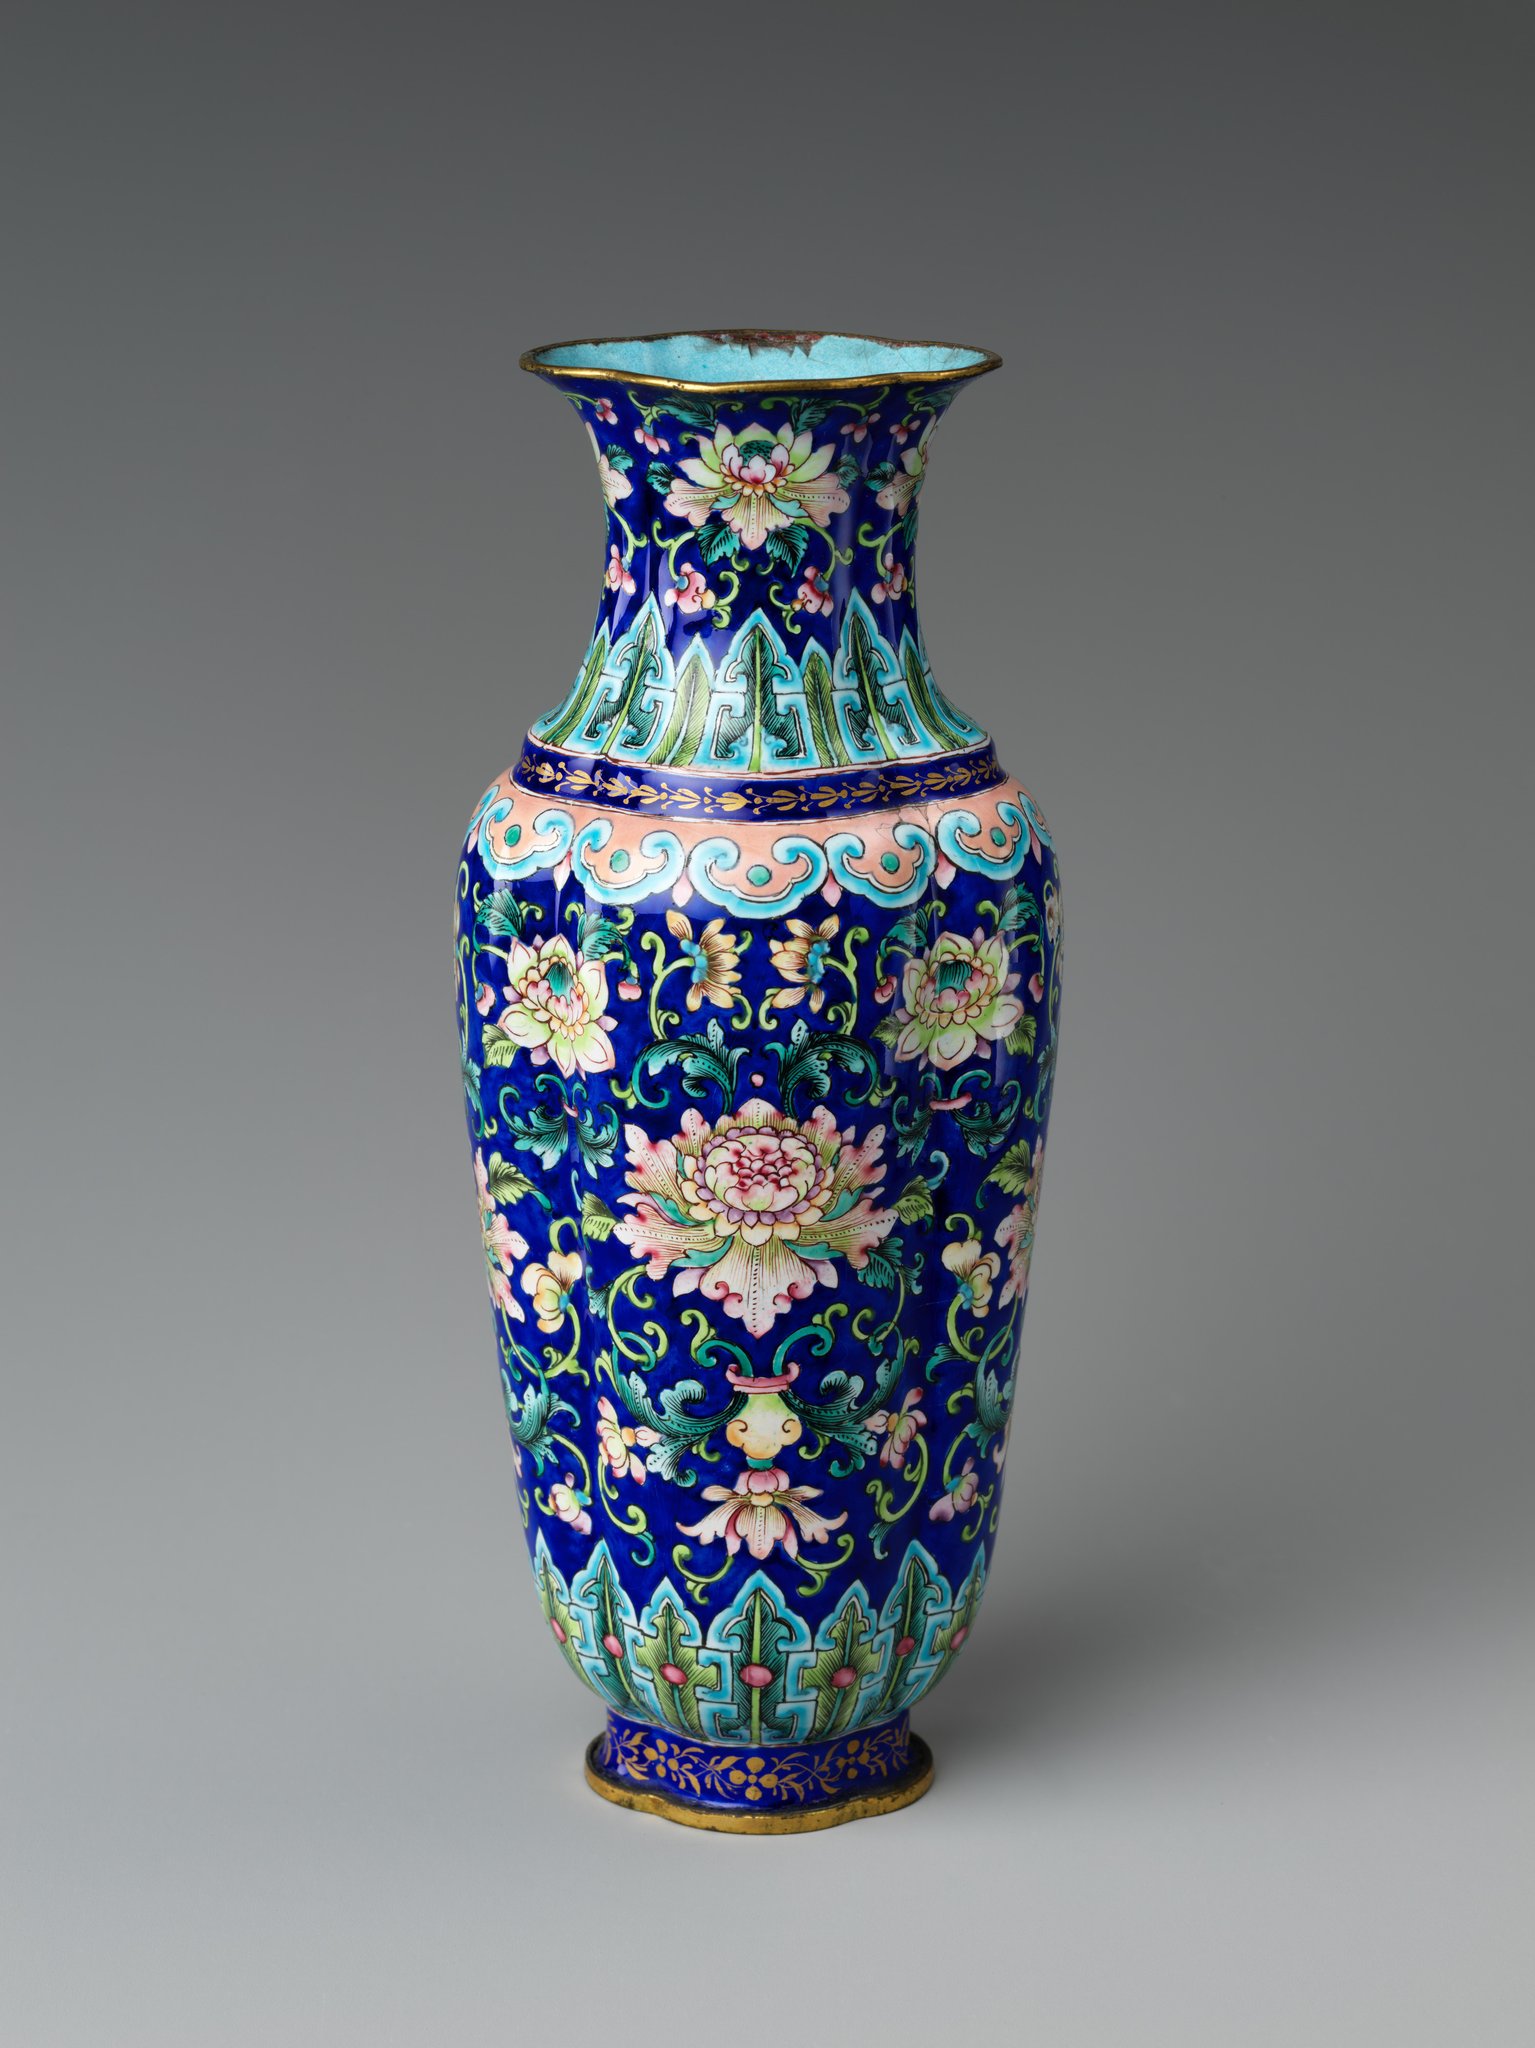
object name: tool bottle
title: Tool bottle (from incense set)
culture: chinese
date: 1751-1800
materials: copper alloy, enamel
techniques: painting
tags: flowers